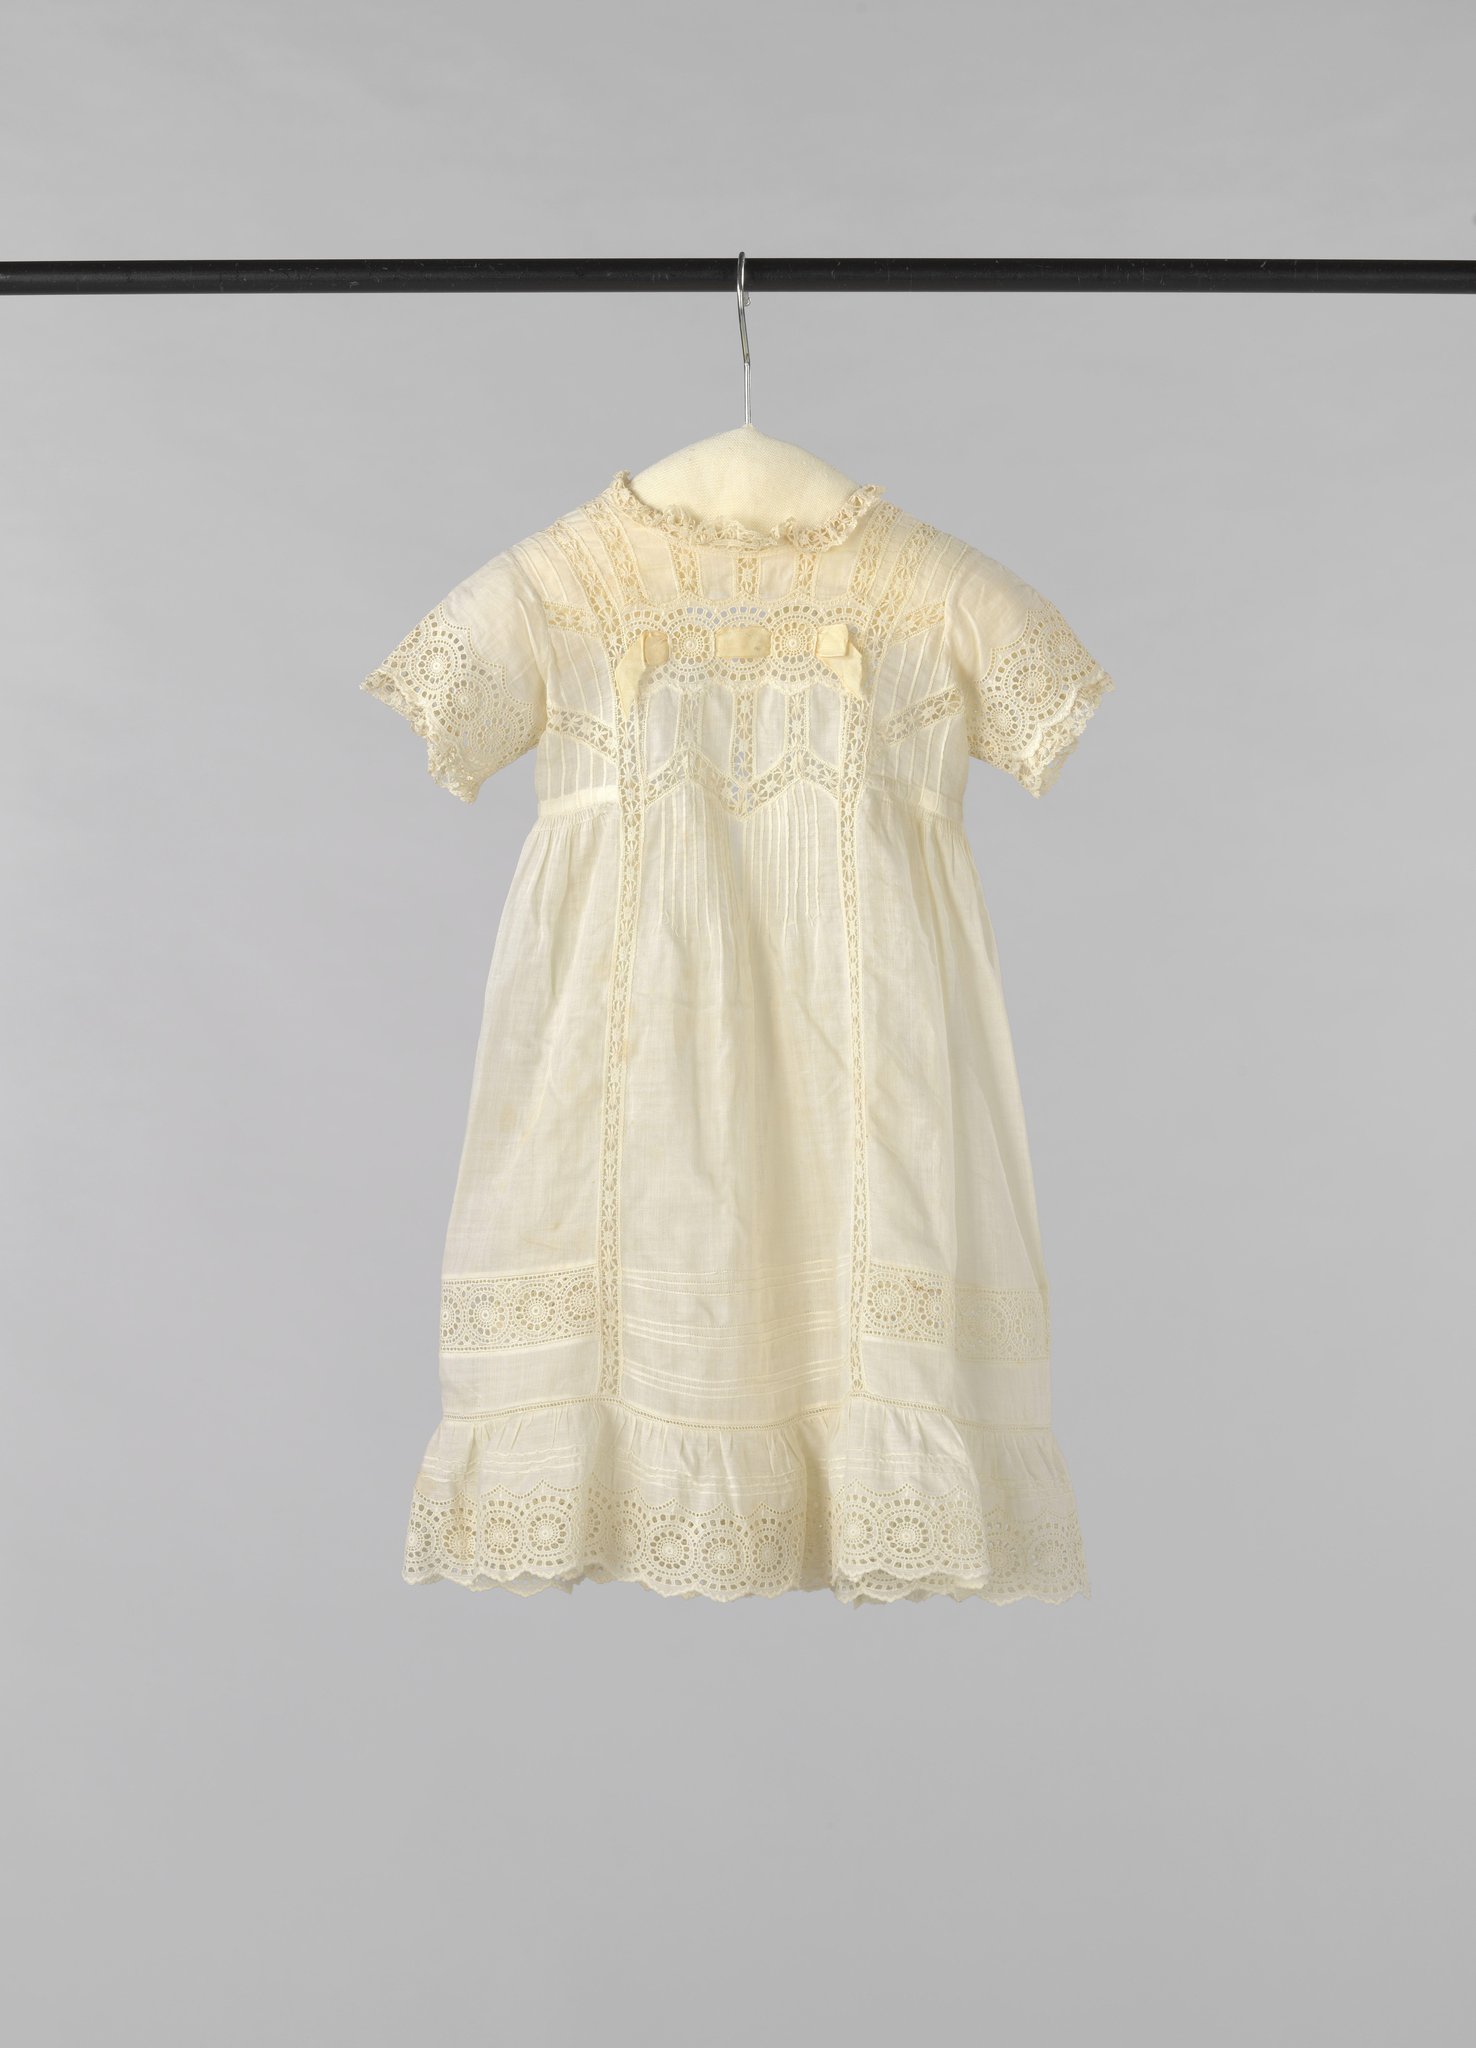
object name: clothing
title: Jurk van witte batist met Engels borduurwerk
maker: Anonymous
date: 1880-1920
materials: textile, cotton